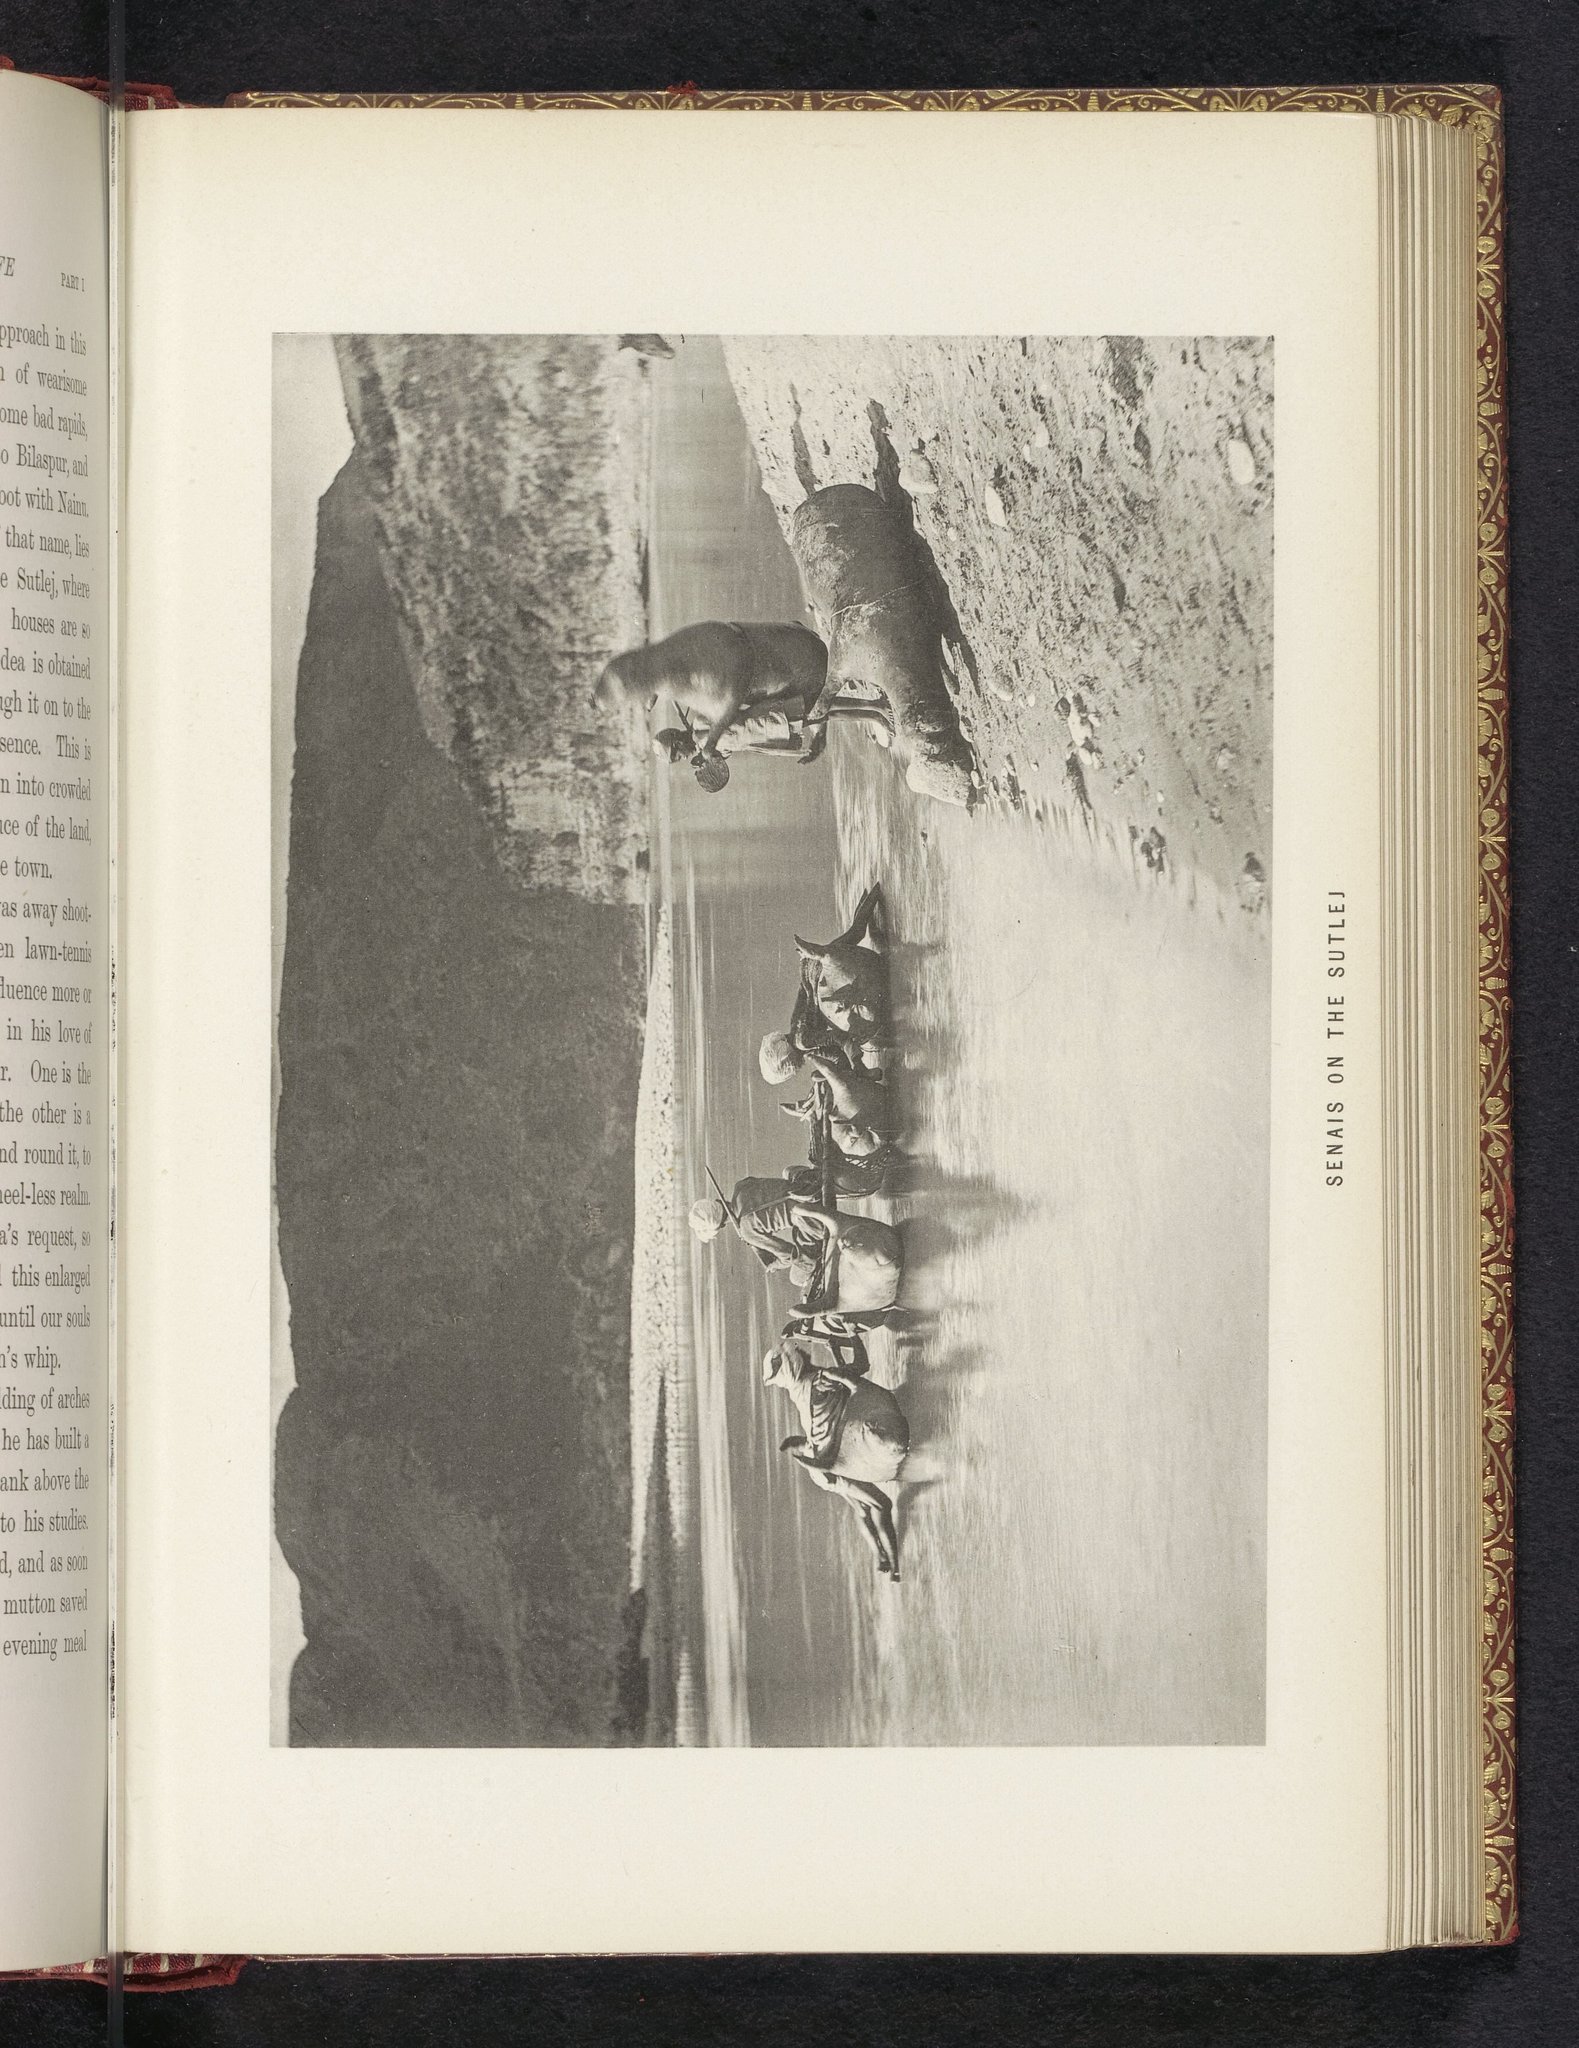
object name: page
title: Boats on the Sutlej River near Bilaspur in Himachal Pradesh, India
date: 1890-1895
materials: paper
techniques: photograph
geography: bilaspur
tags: river, rowing-boat, canoe, etc.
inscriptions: caption: ‘SENAIS ON THE SUTLEJ’